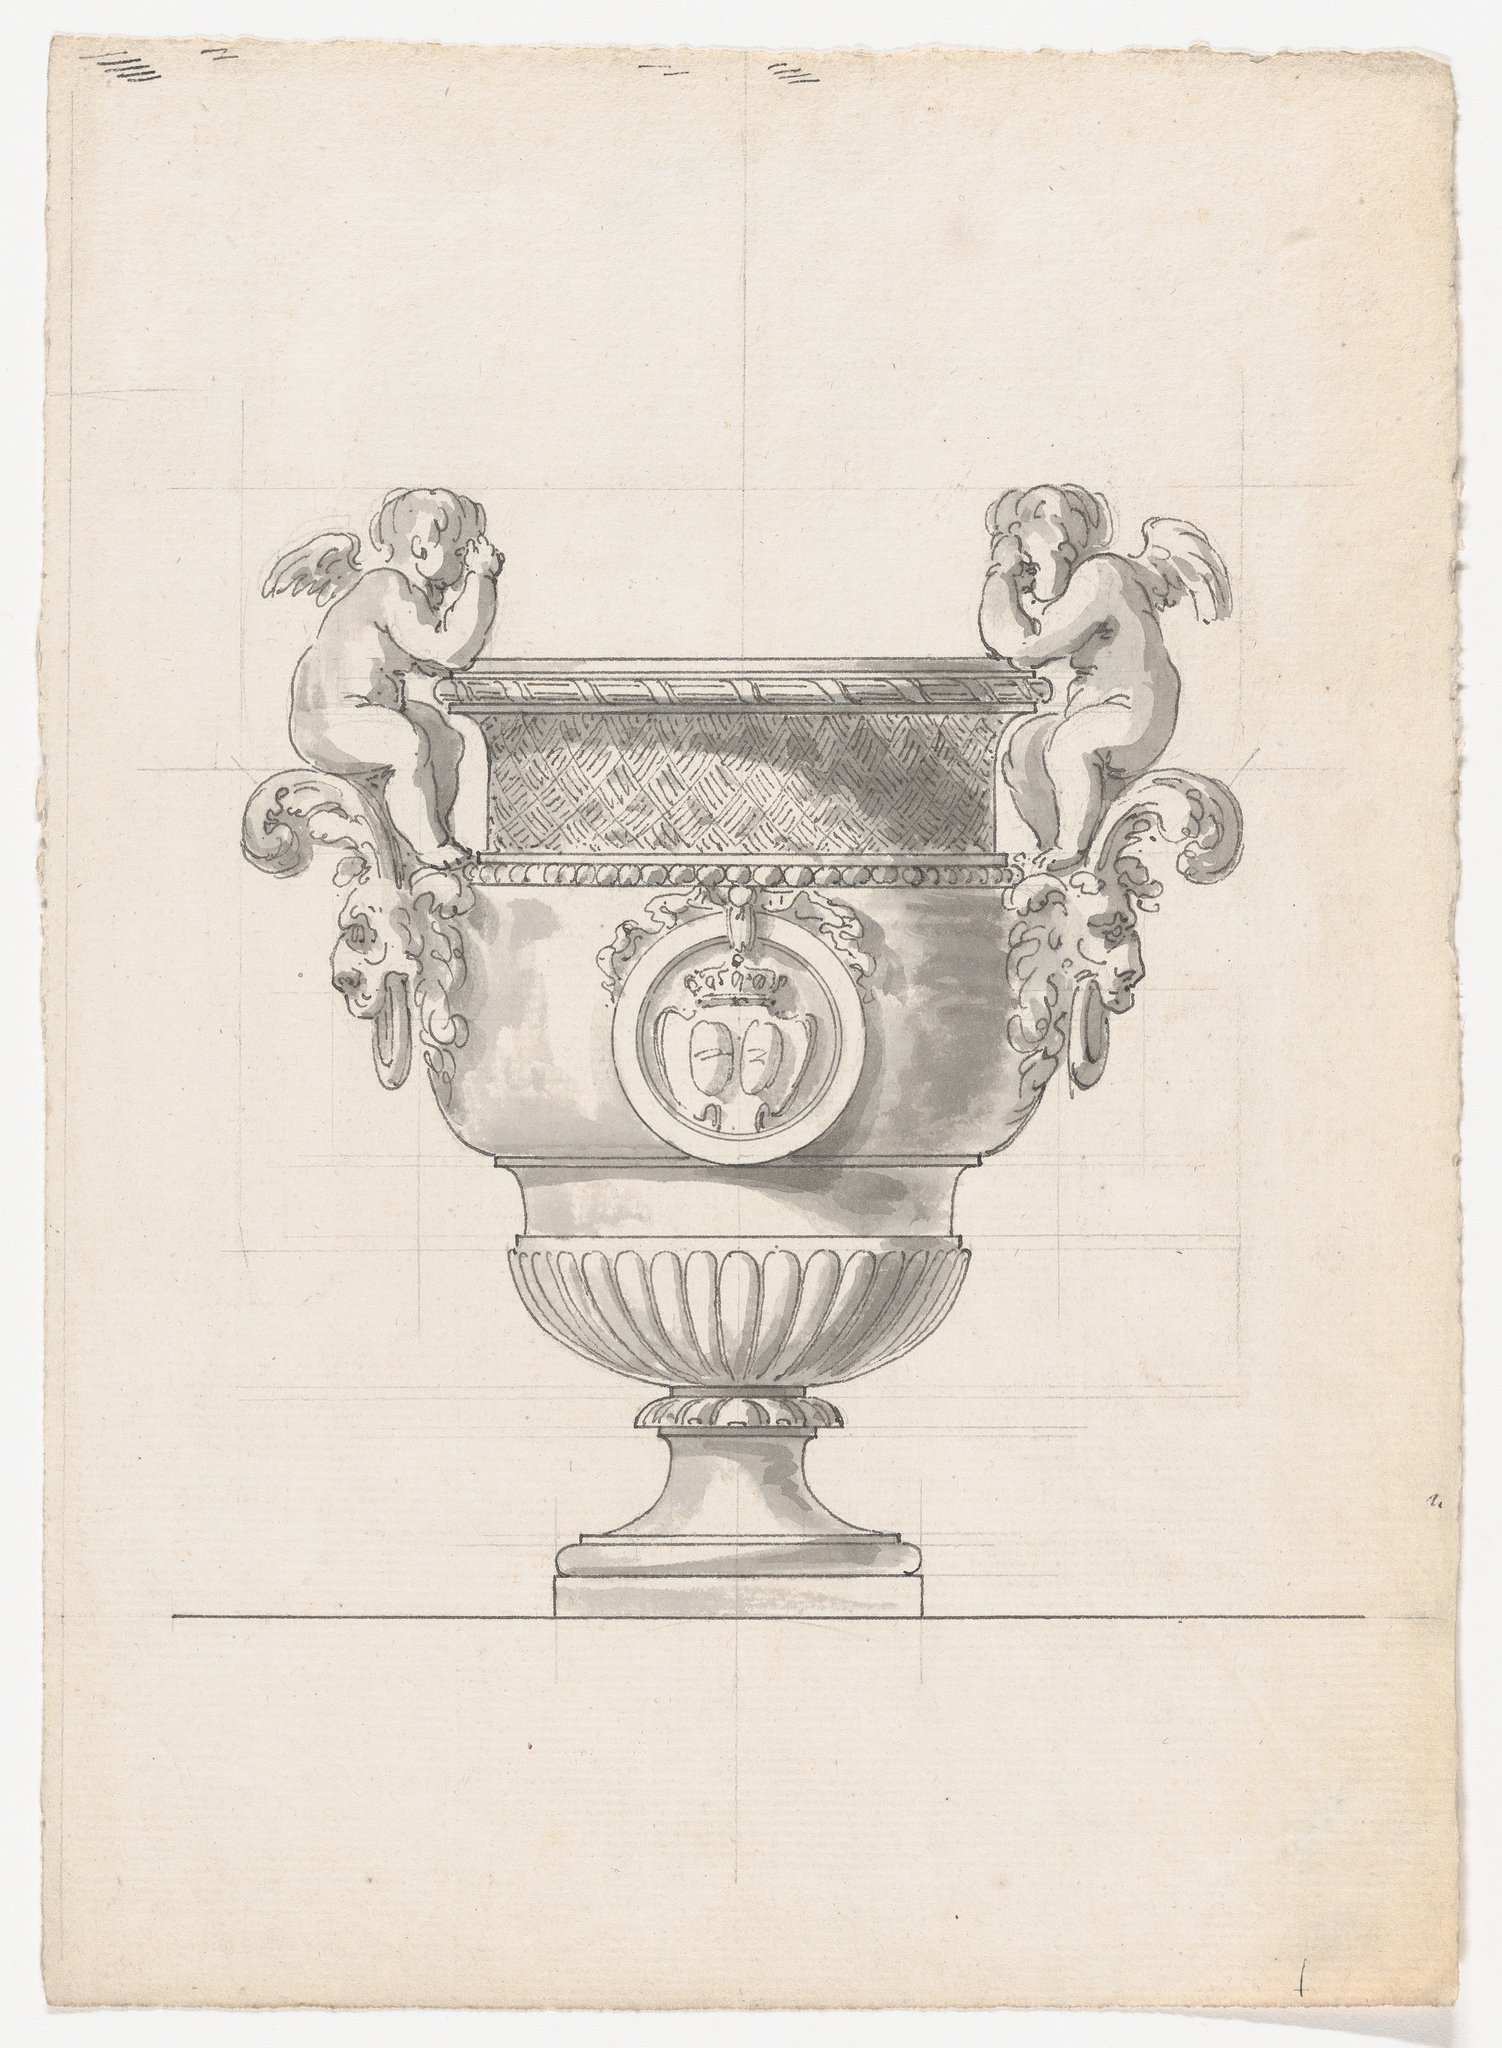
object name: drawing ornament architecture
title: Bronze Garden Vase with Two Putti from the Gardens of Versailles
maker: claude ballin the elder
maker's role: artist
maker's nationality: french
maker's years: 1615-1678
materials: graphite, ink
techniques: pen, wash